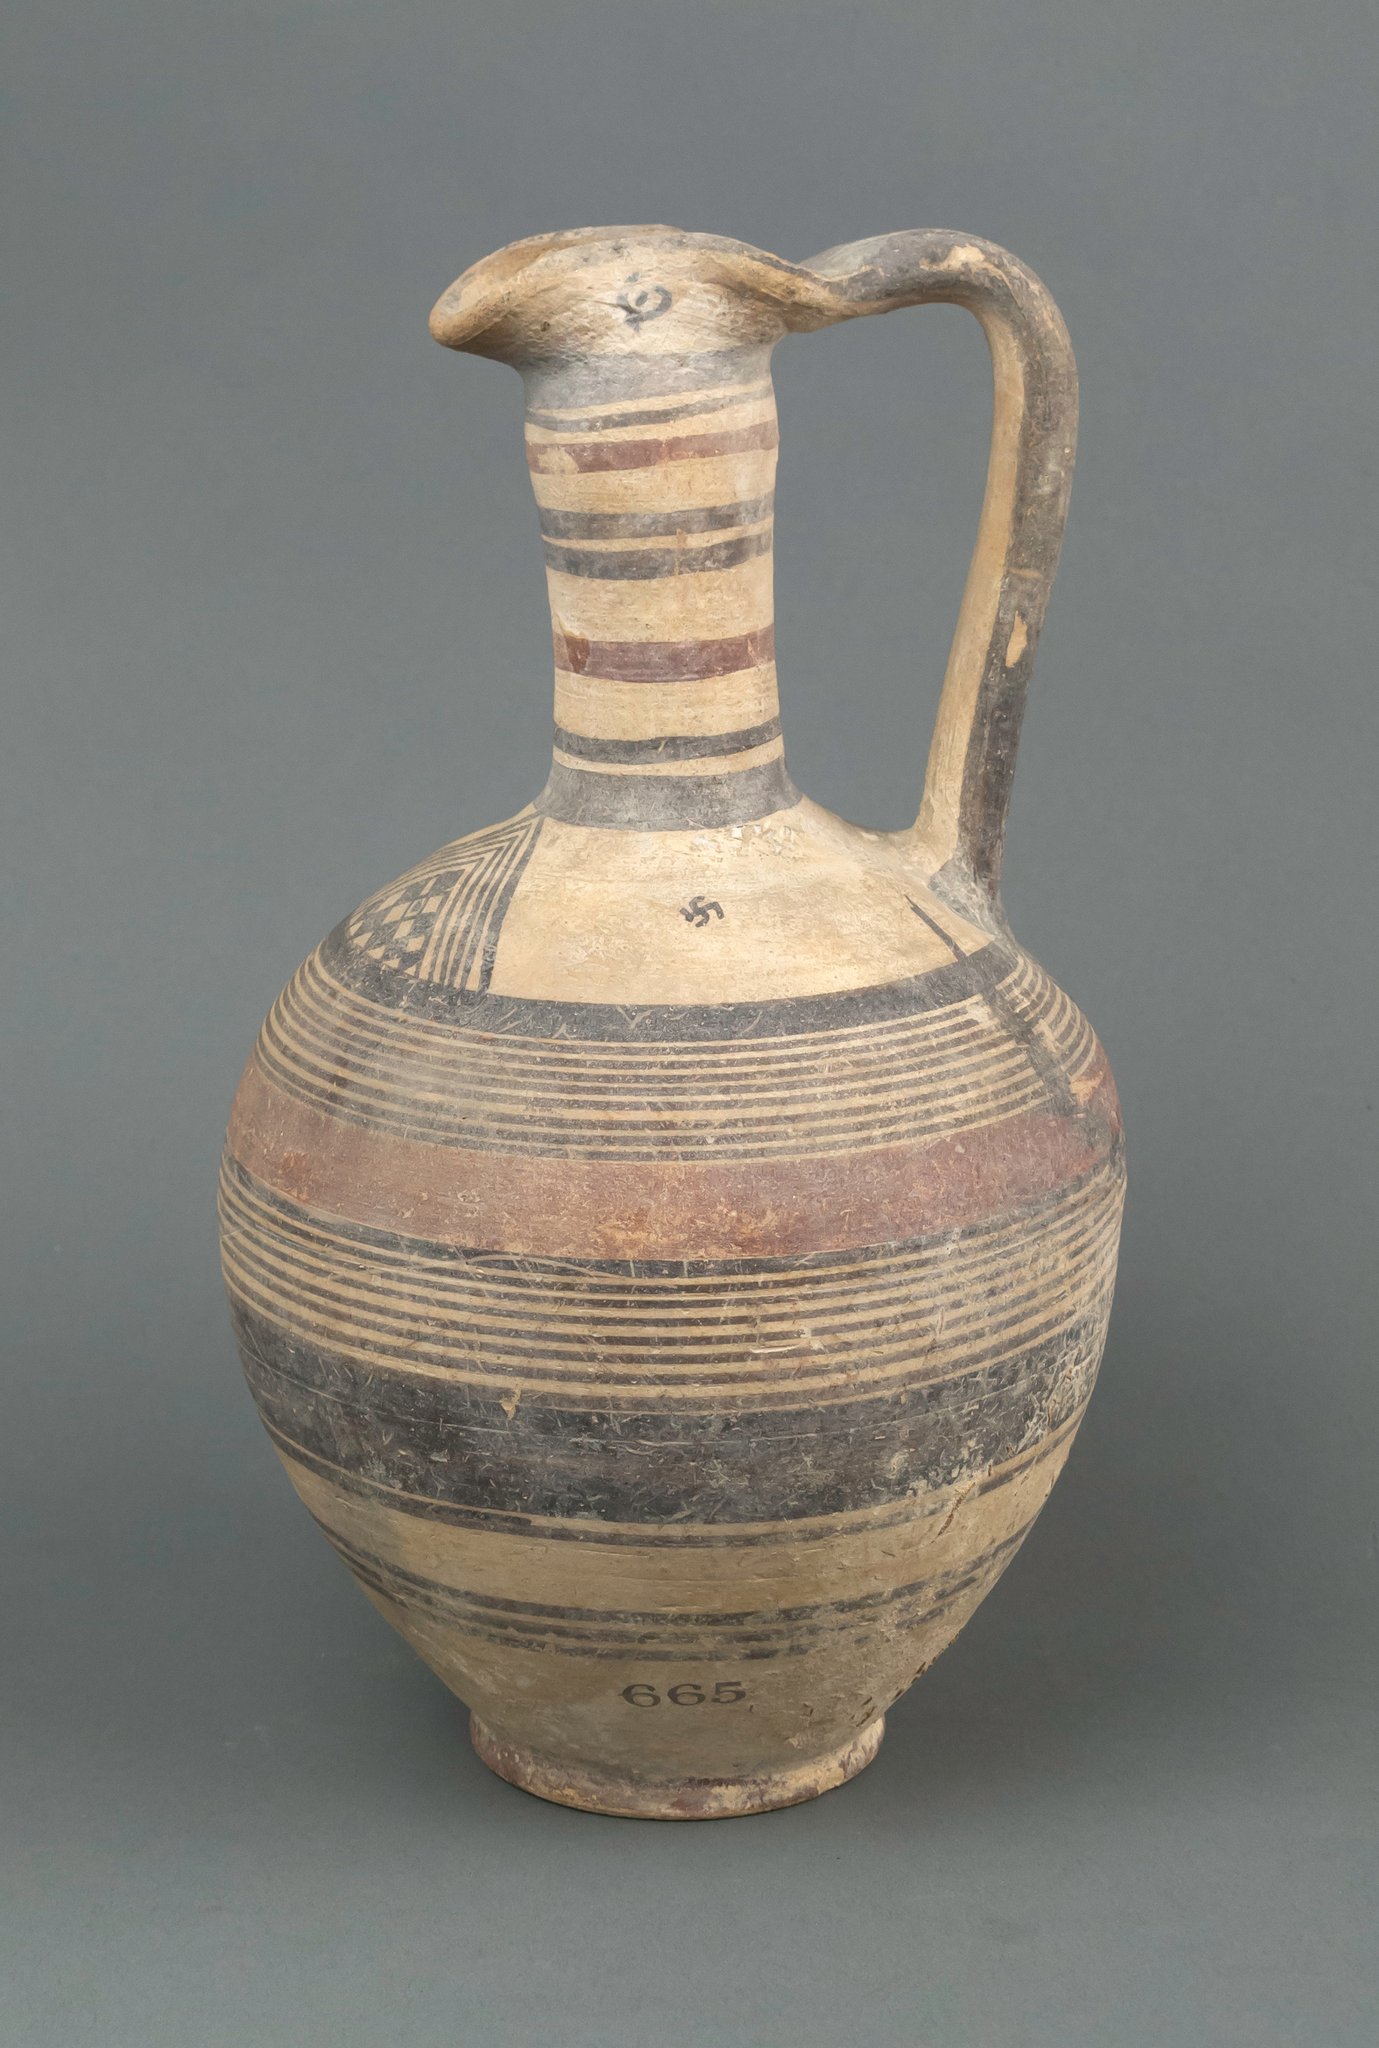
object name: oinochoe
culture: cypriot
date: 1050-900 BCE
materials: terracotta